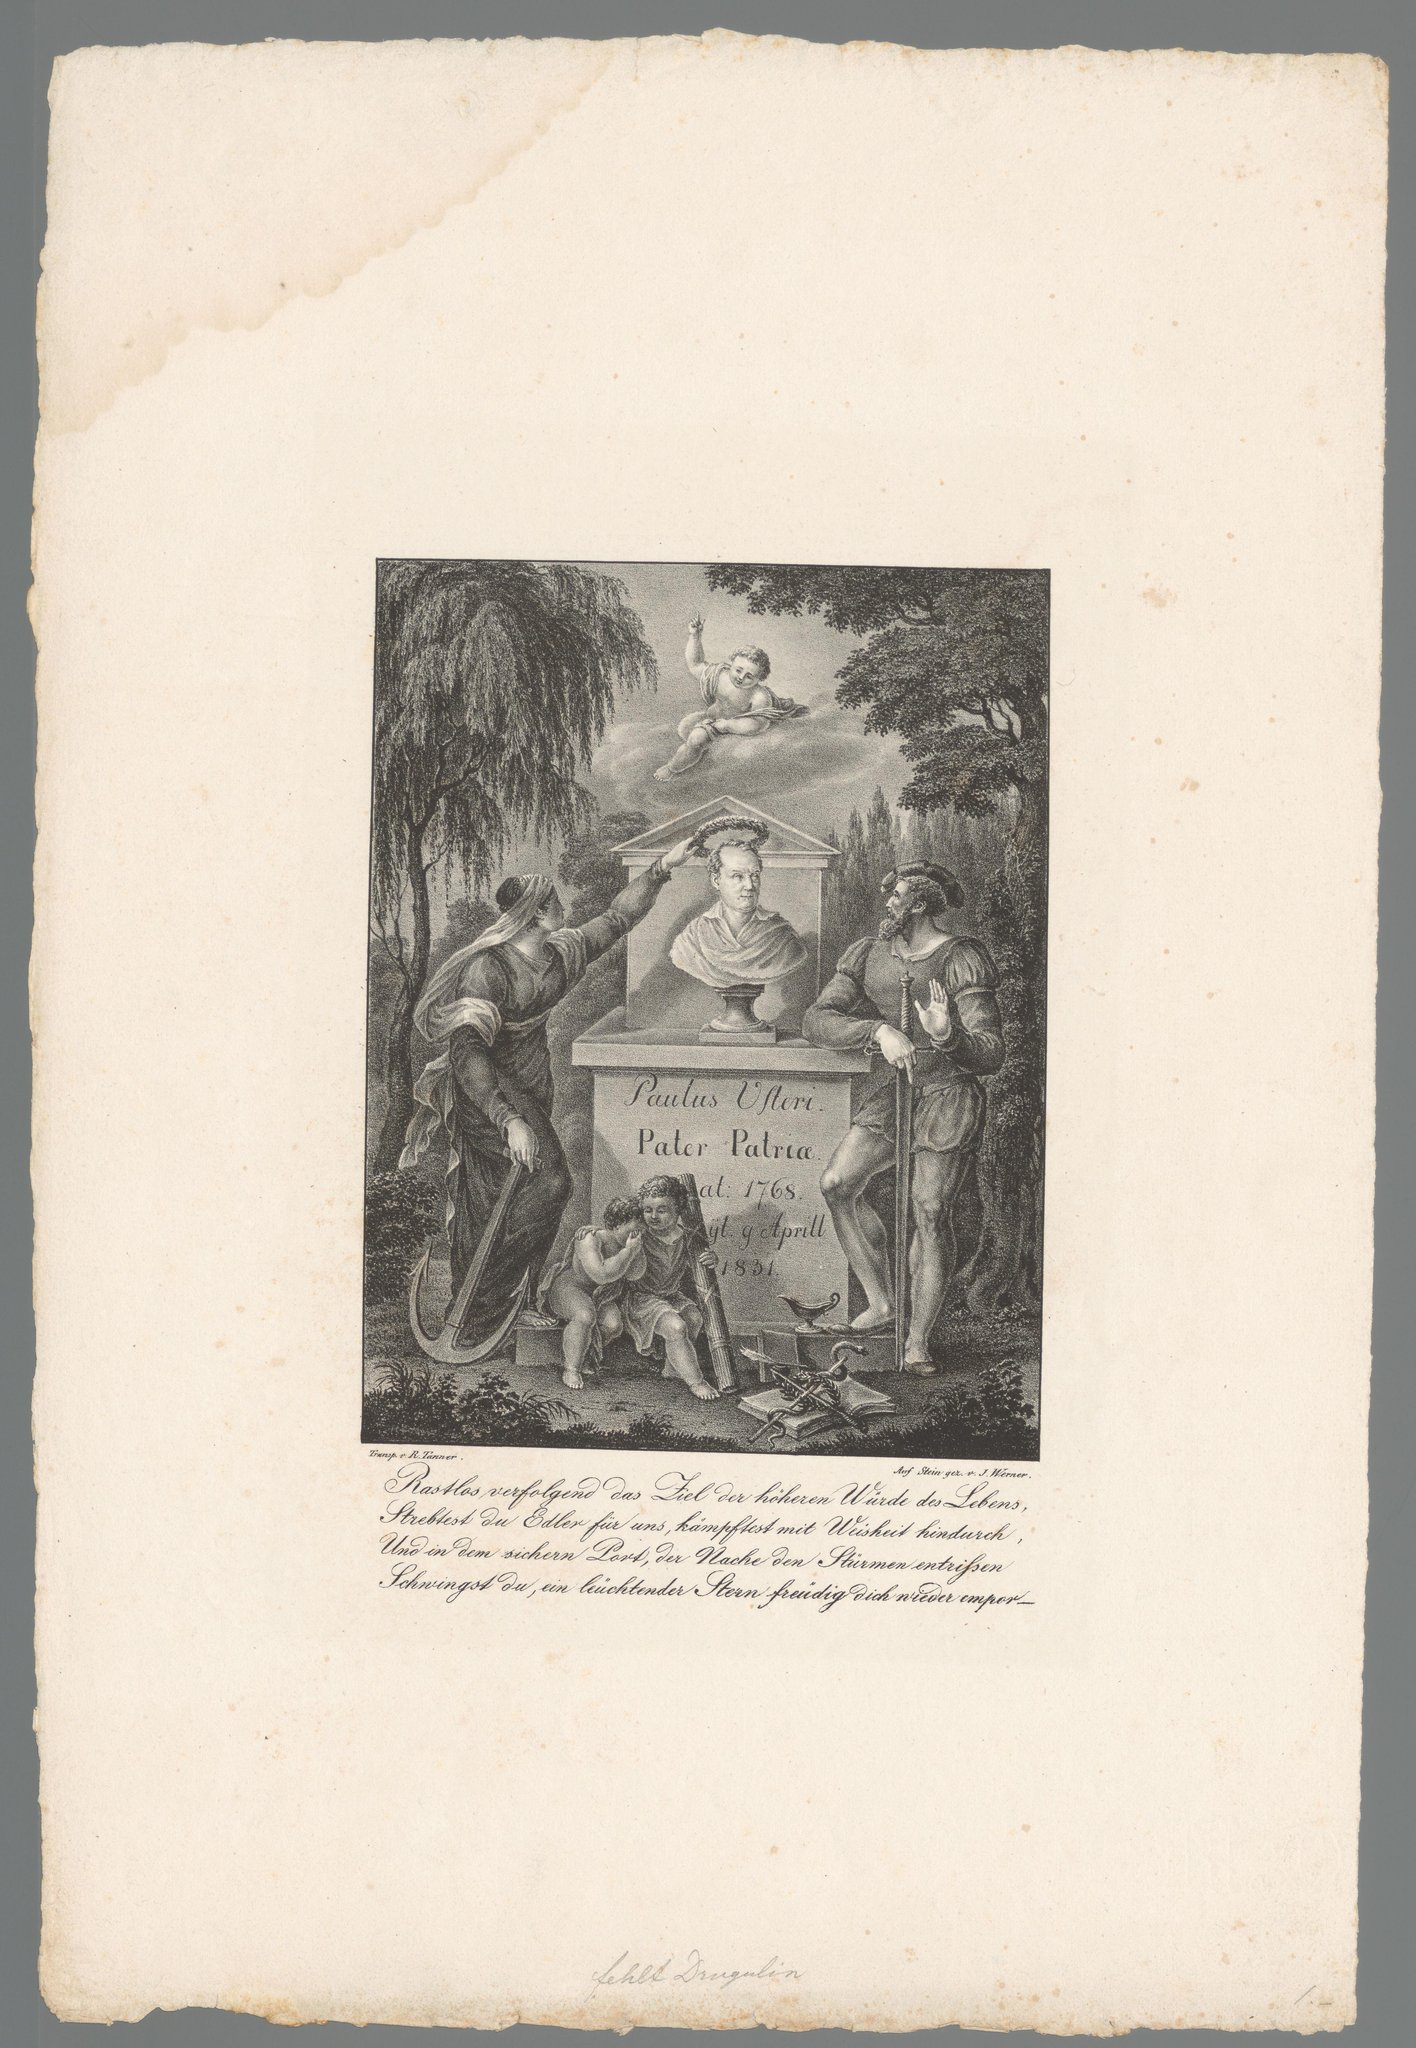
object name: print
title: Monument voor Paul Usteri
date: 1831-1850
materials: paper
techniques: lithograph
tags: historical persons, landscape with monument, crowning with laurel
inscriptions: collector's mark: Lugt 2228